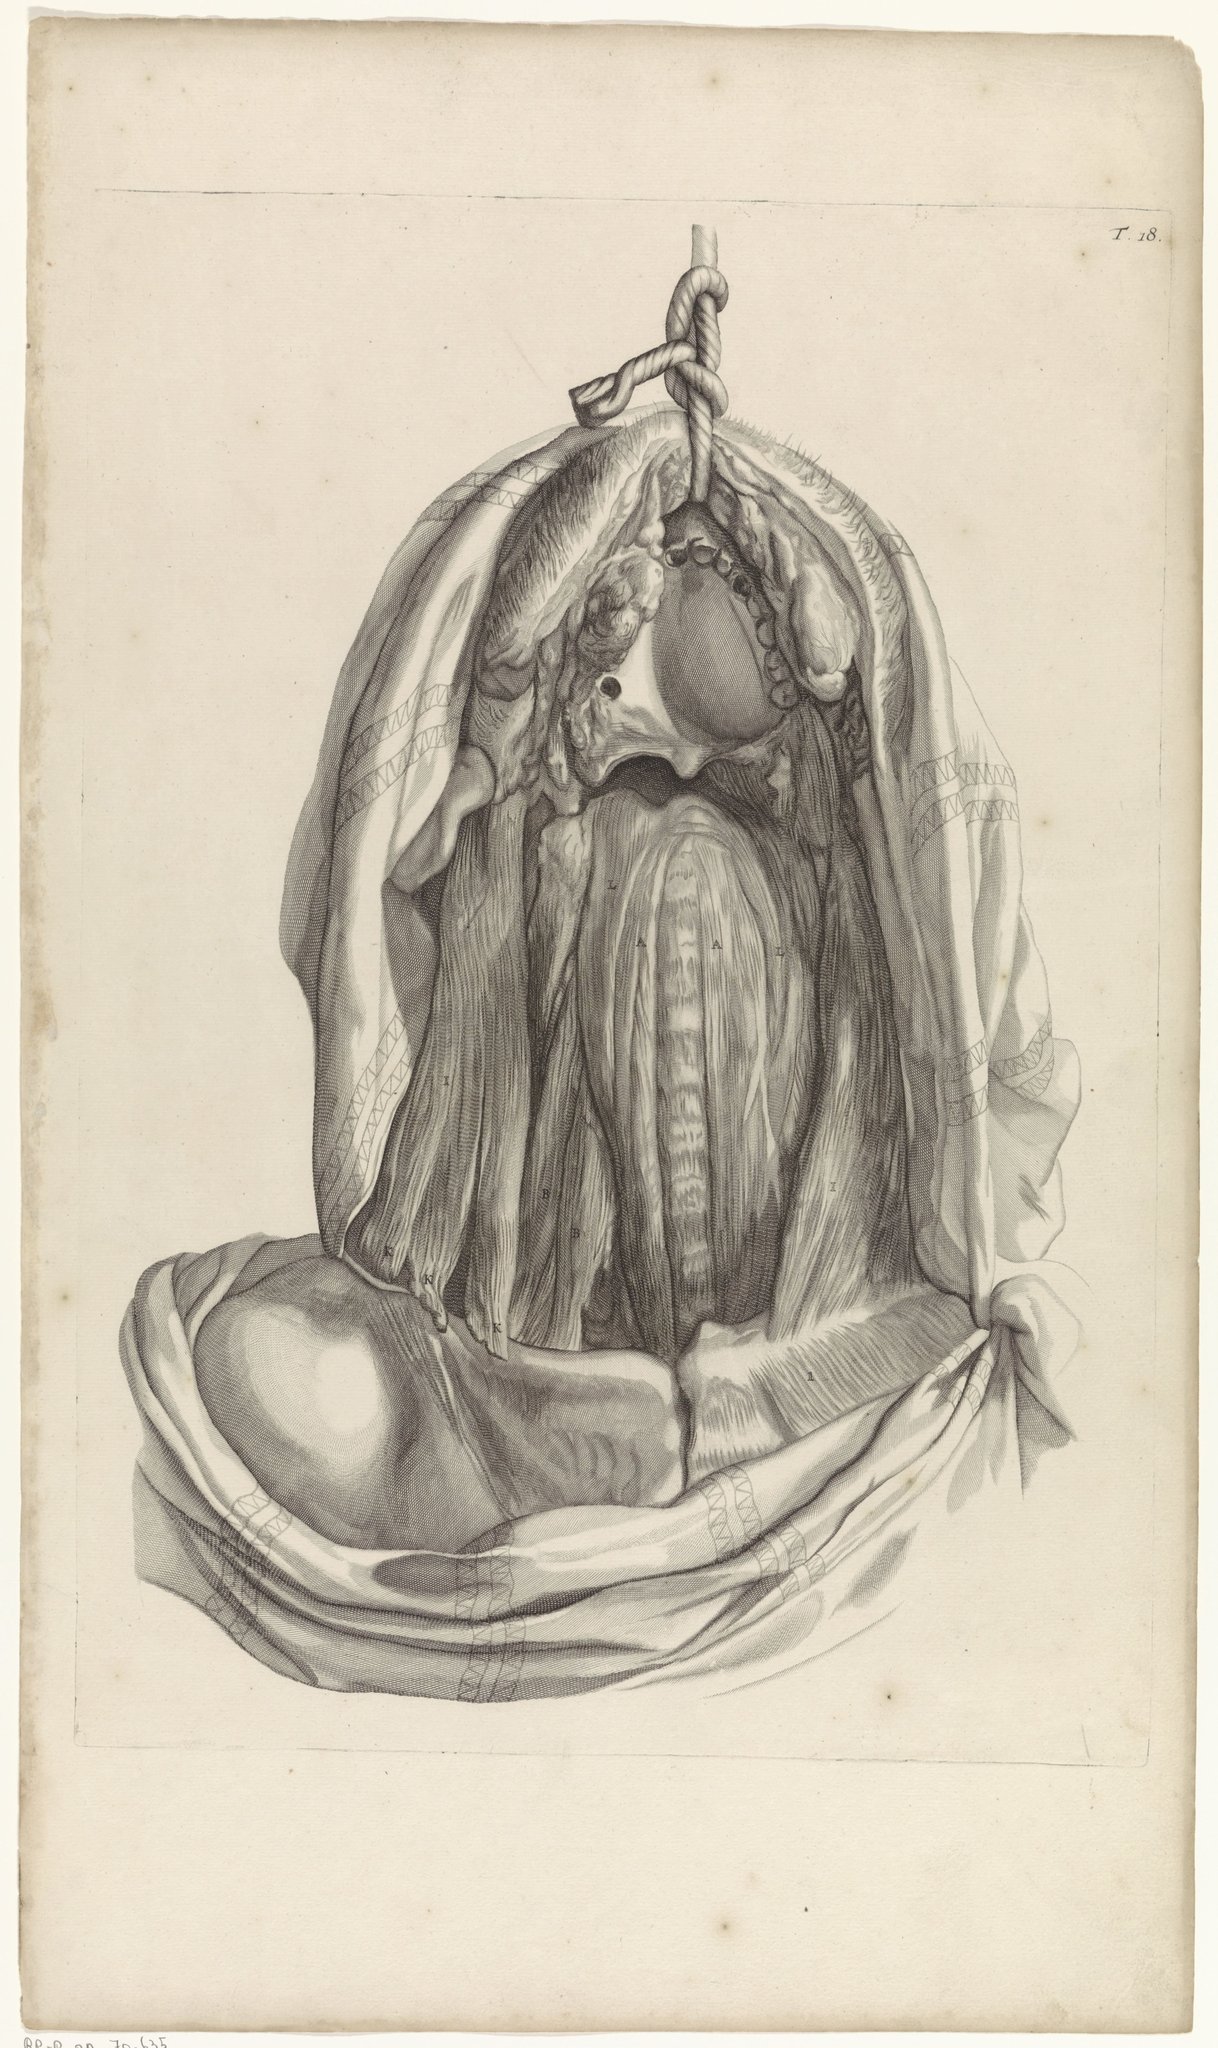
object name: book illustration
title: Anatomische studie van de binnenkant van het hoofd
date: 1685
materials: paper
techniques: engraving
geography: amsterdam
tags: head (internal) (+ front view)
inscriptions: collector's mark: Lugt 2228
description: Boekillustratie voor Bidloo, Godefridus. Anatomia humani corporis centum & quinque tabulis, per art. G. de Lairesse ad vivum delineatis, de monstrata, veterum recentiorumque inventis explicata plurimisque, hactenus non detectis, illustrata. Amsterdam: Weduwe Joannes van Someren, Hendrick Boom en erven Dirk Boom, 1685.